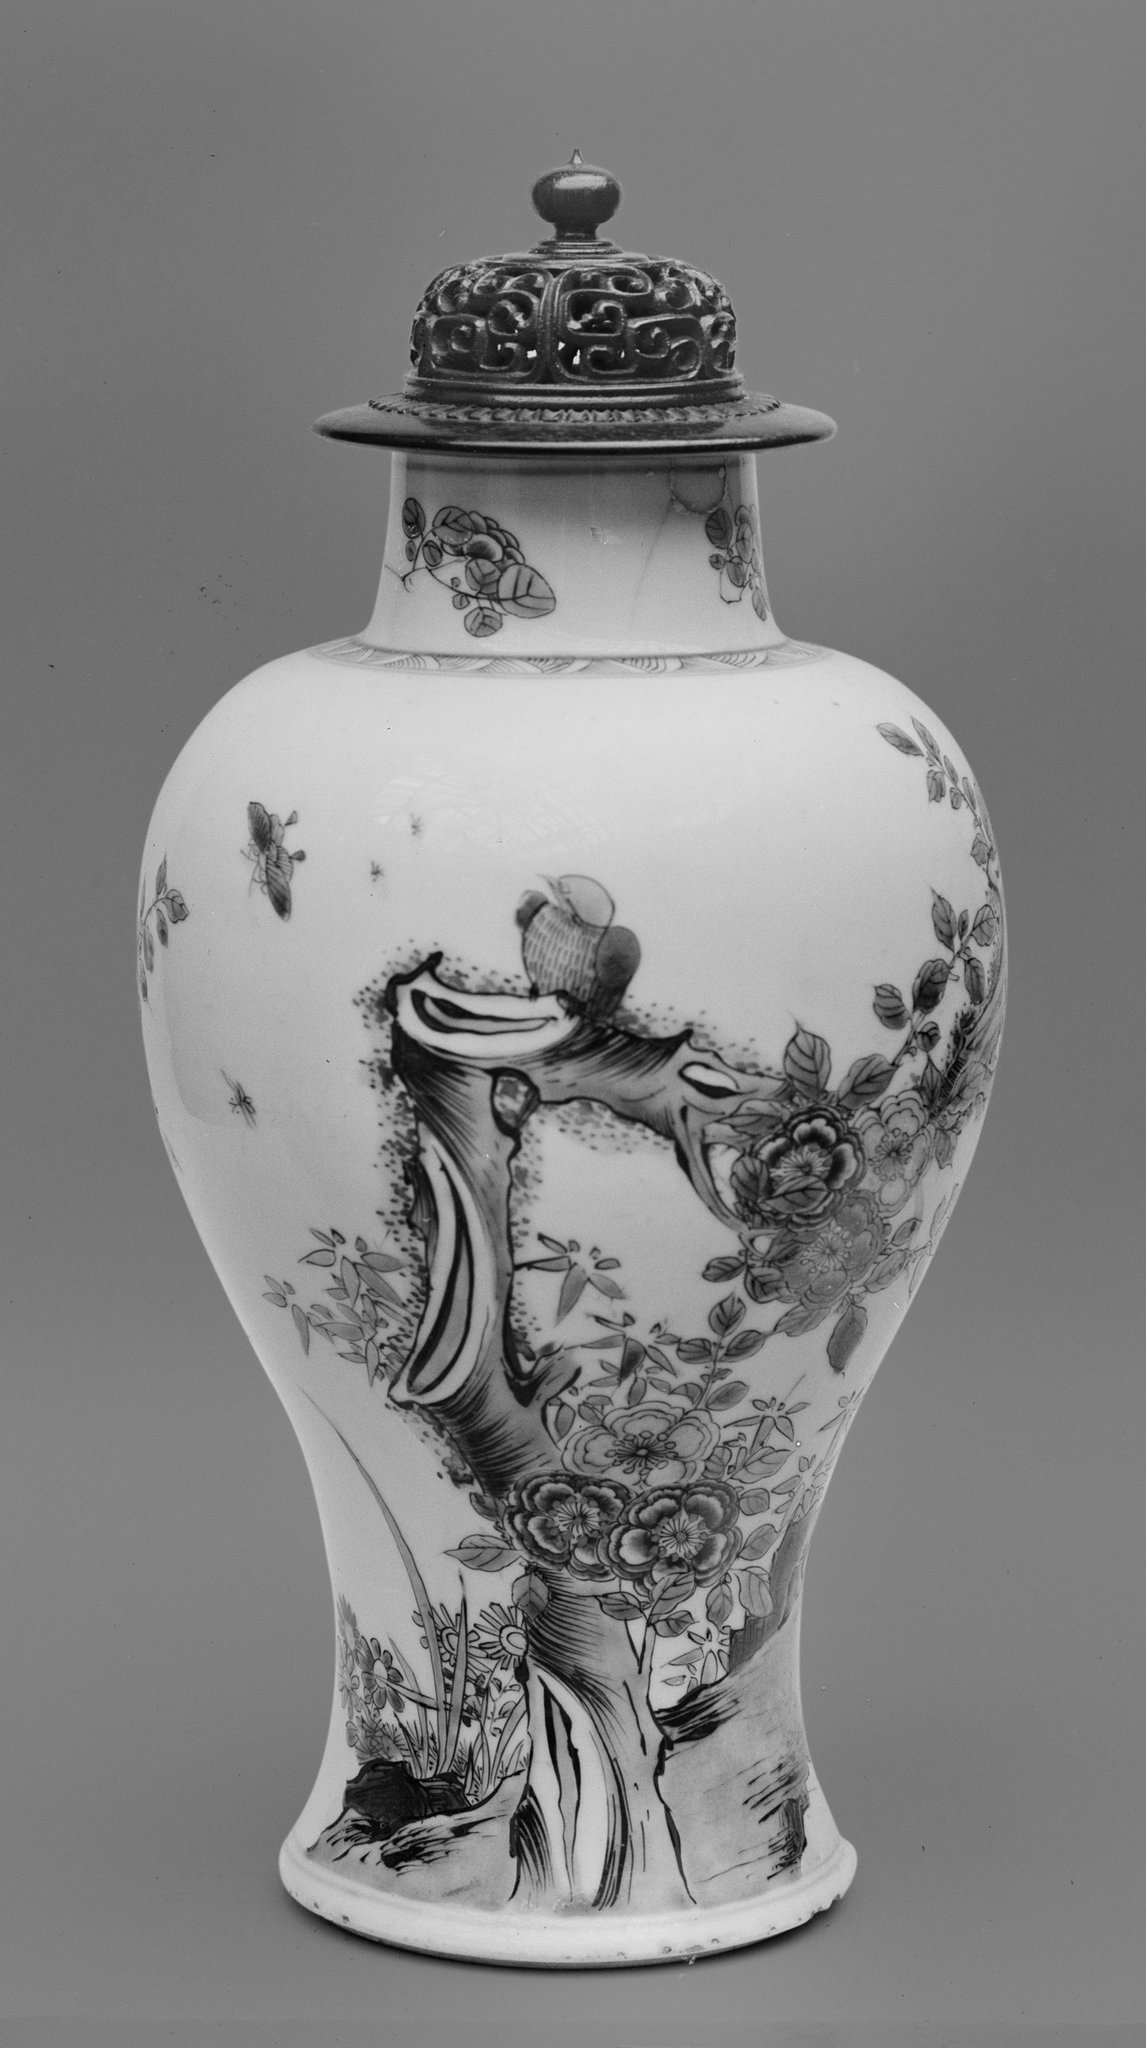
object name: jar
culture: chinese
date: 1662-1722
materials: porcelain